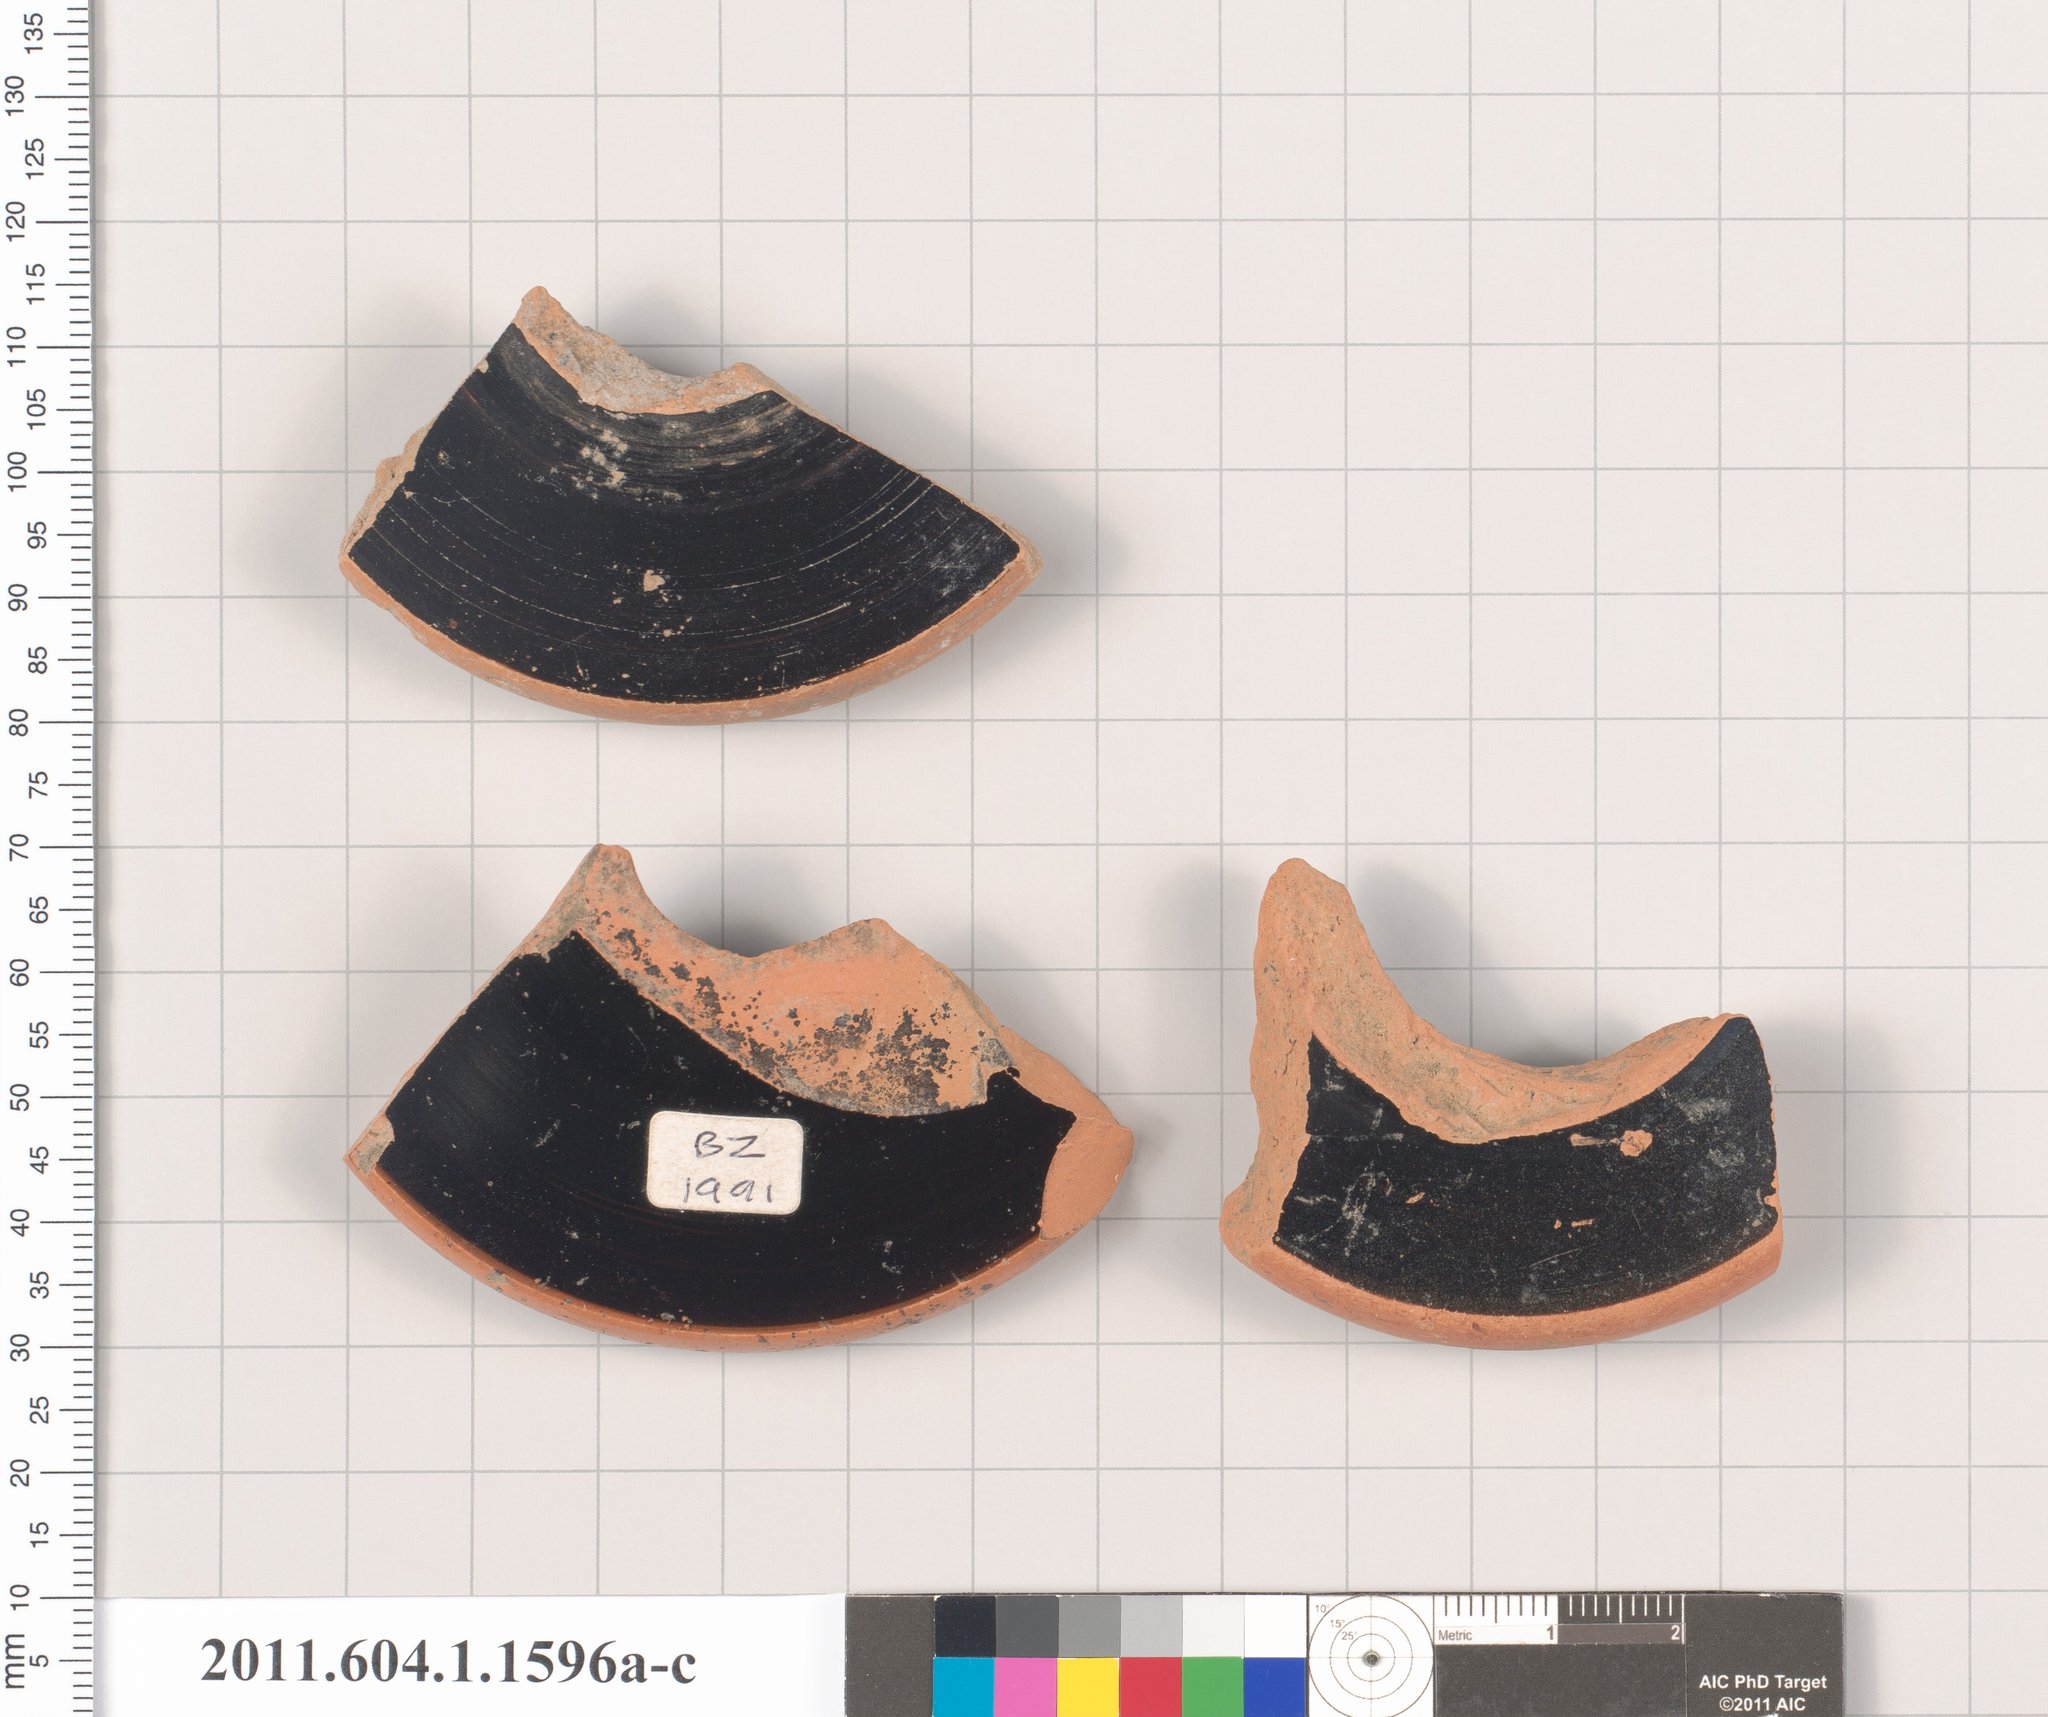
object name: kylix fragment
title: Terracotta fragments of kylikes (drinking cups)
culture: greek, attic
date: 500-401 BCE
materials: terracotta